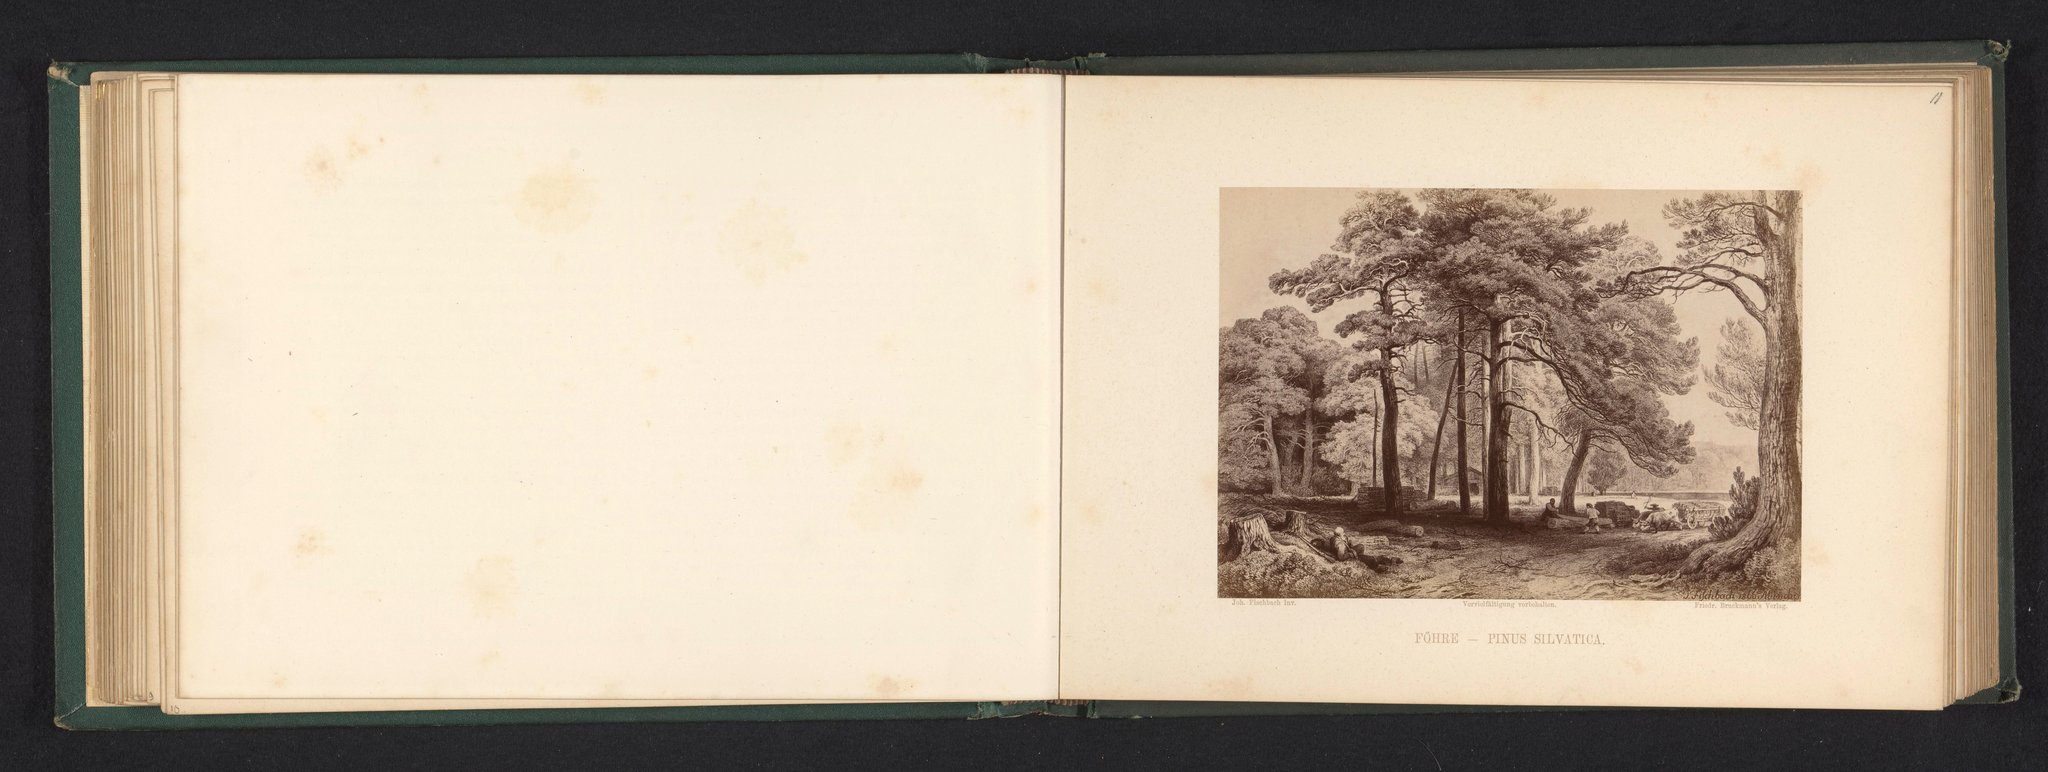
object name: reproduction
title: Fotoreproductie van een tekening van een landschap met grove dennen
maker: johann fischbach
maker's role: painter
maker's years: 1797-1871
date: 1866-1879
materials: photographic support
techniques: albumen print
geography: munich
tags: trees: pine